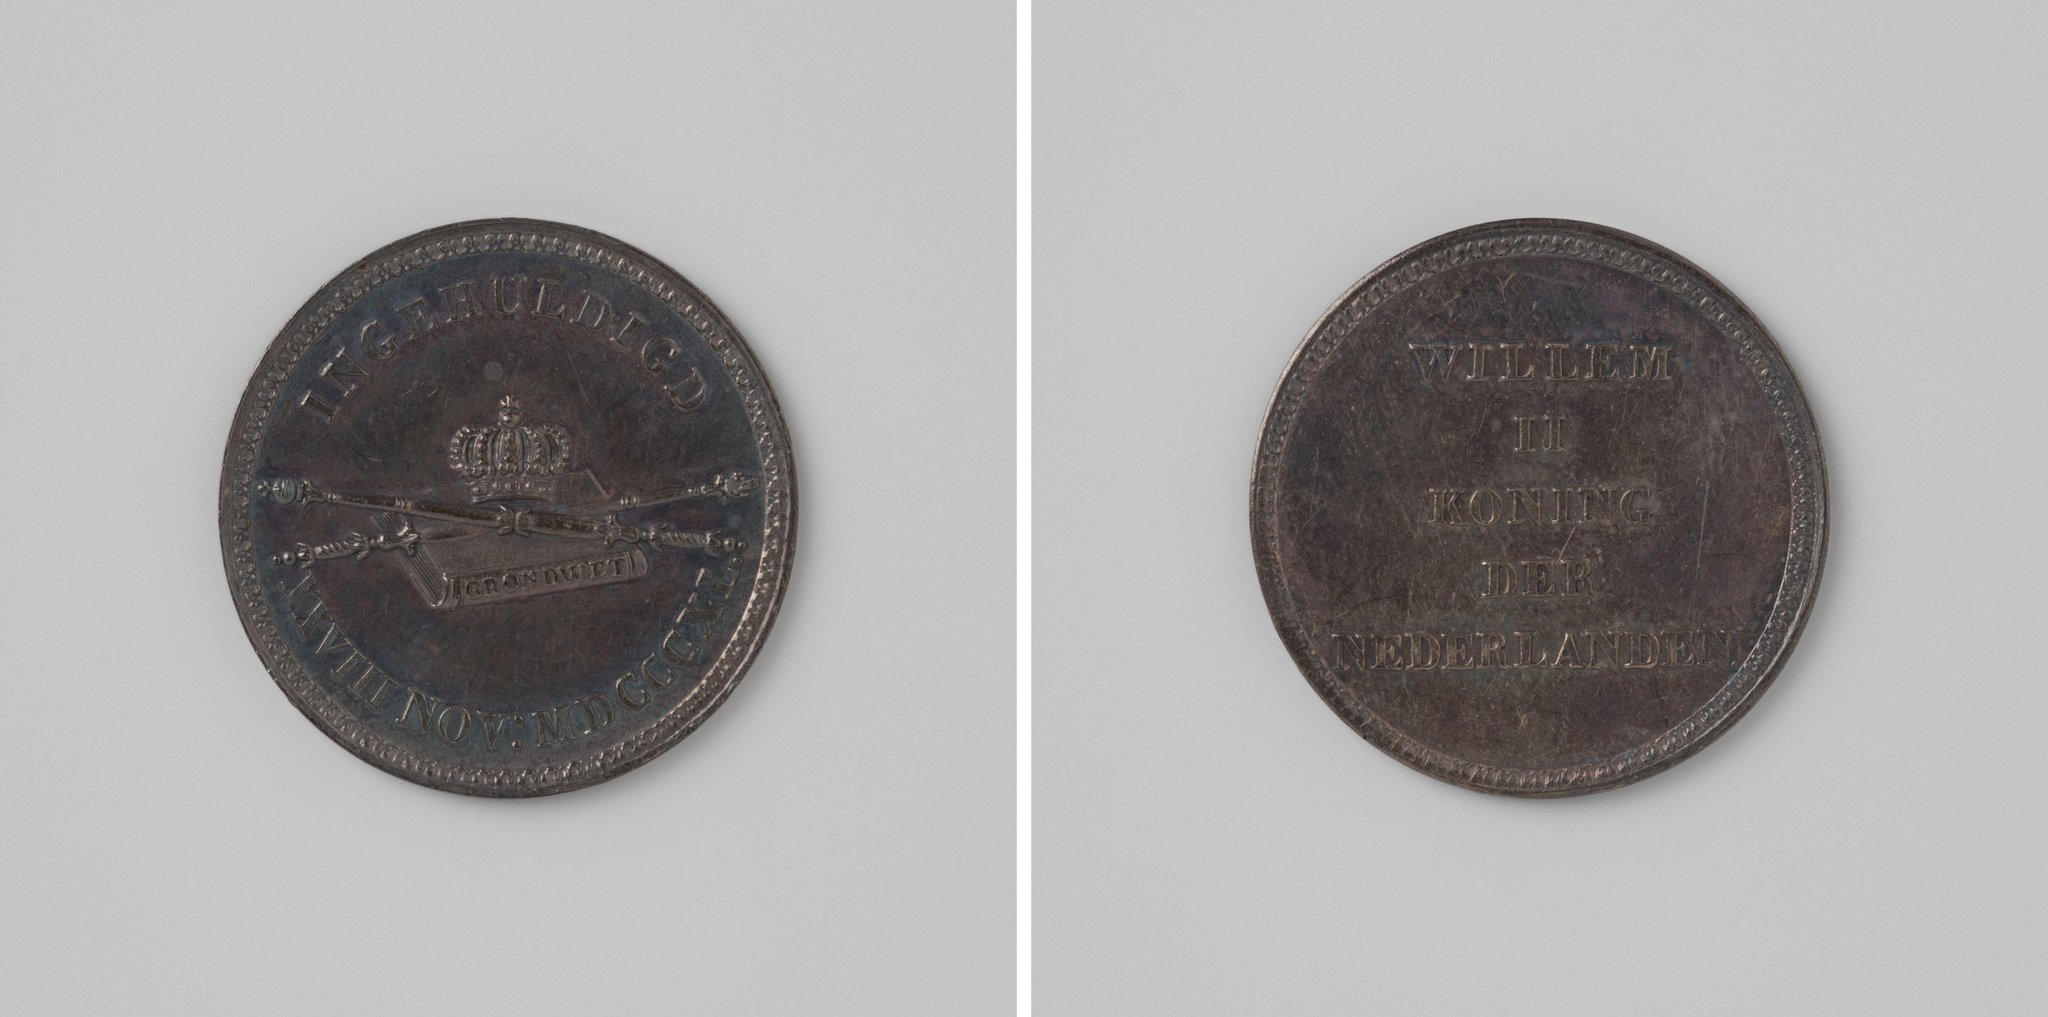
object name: history medal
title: Strooipenning bij de inhuldiging van Koning Willem II te Amsterdam 1840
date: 1840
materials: silver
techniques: striking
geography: utrecht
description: Zilveren penning, op de voorzijde de grondwet waarop kroon en scepter, met omschrift, op de keerzijde vier regels tekst.